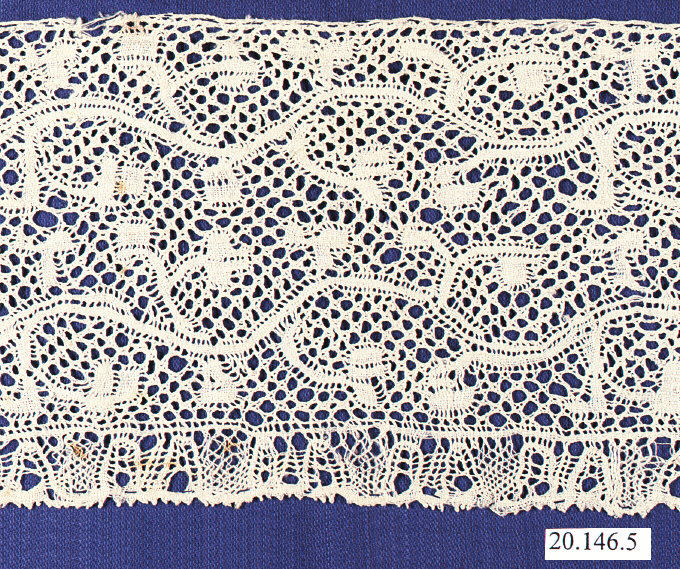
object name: strip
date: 1701-1800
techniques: lace